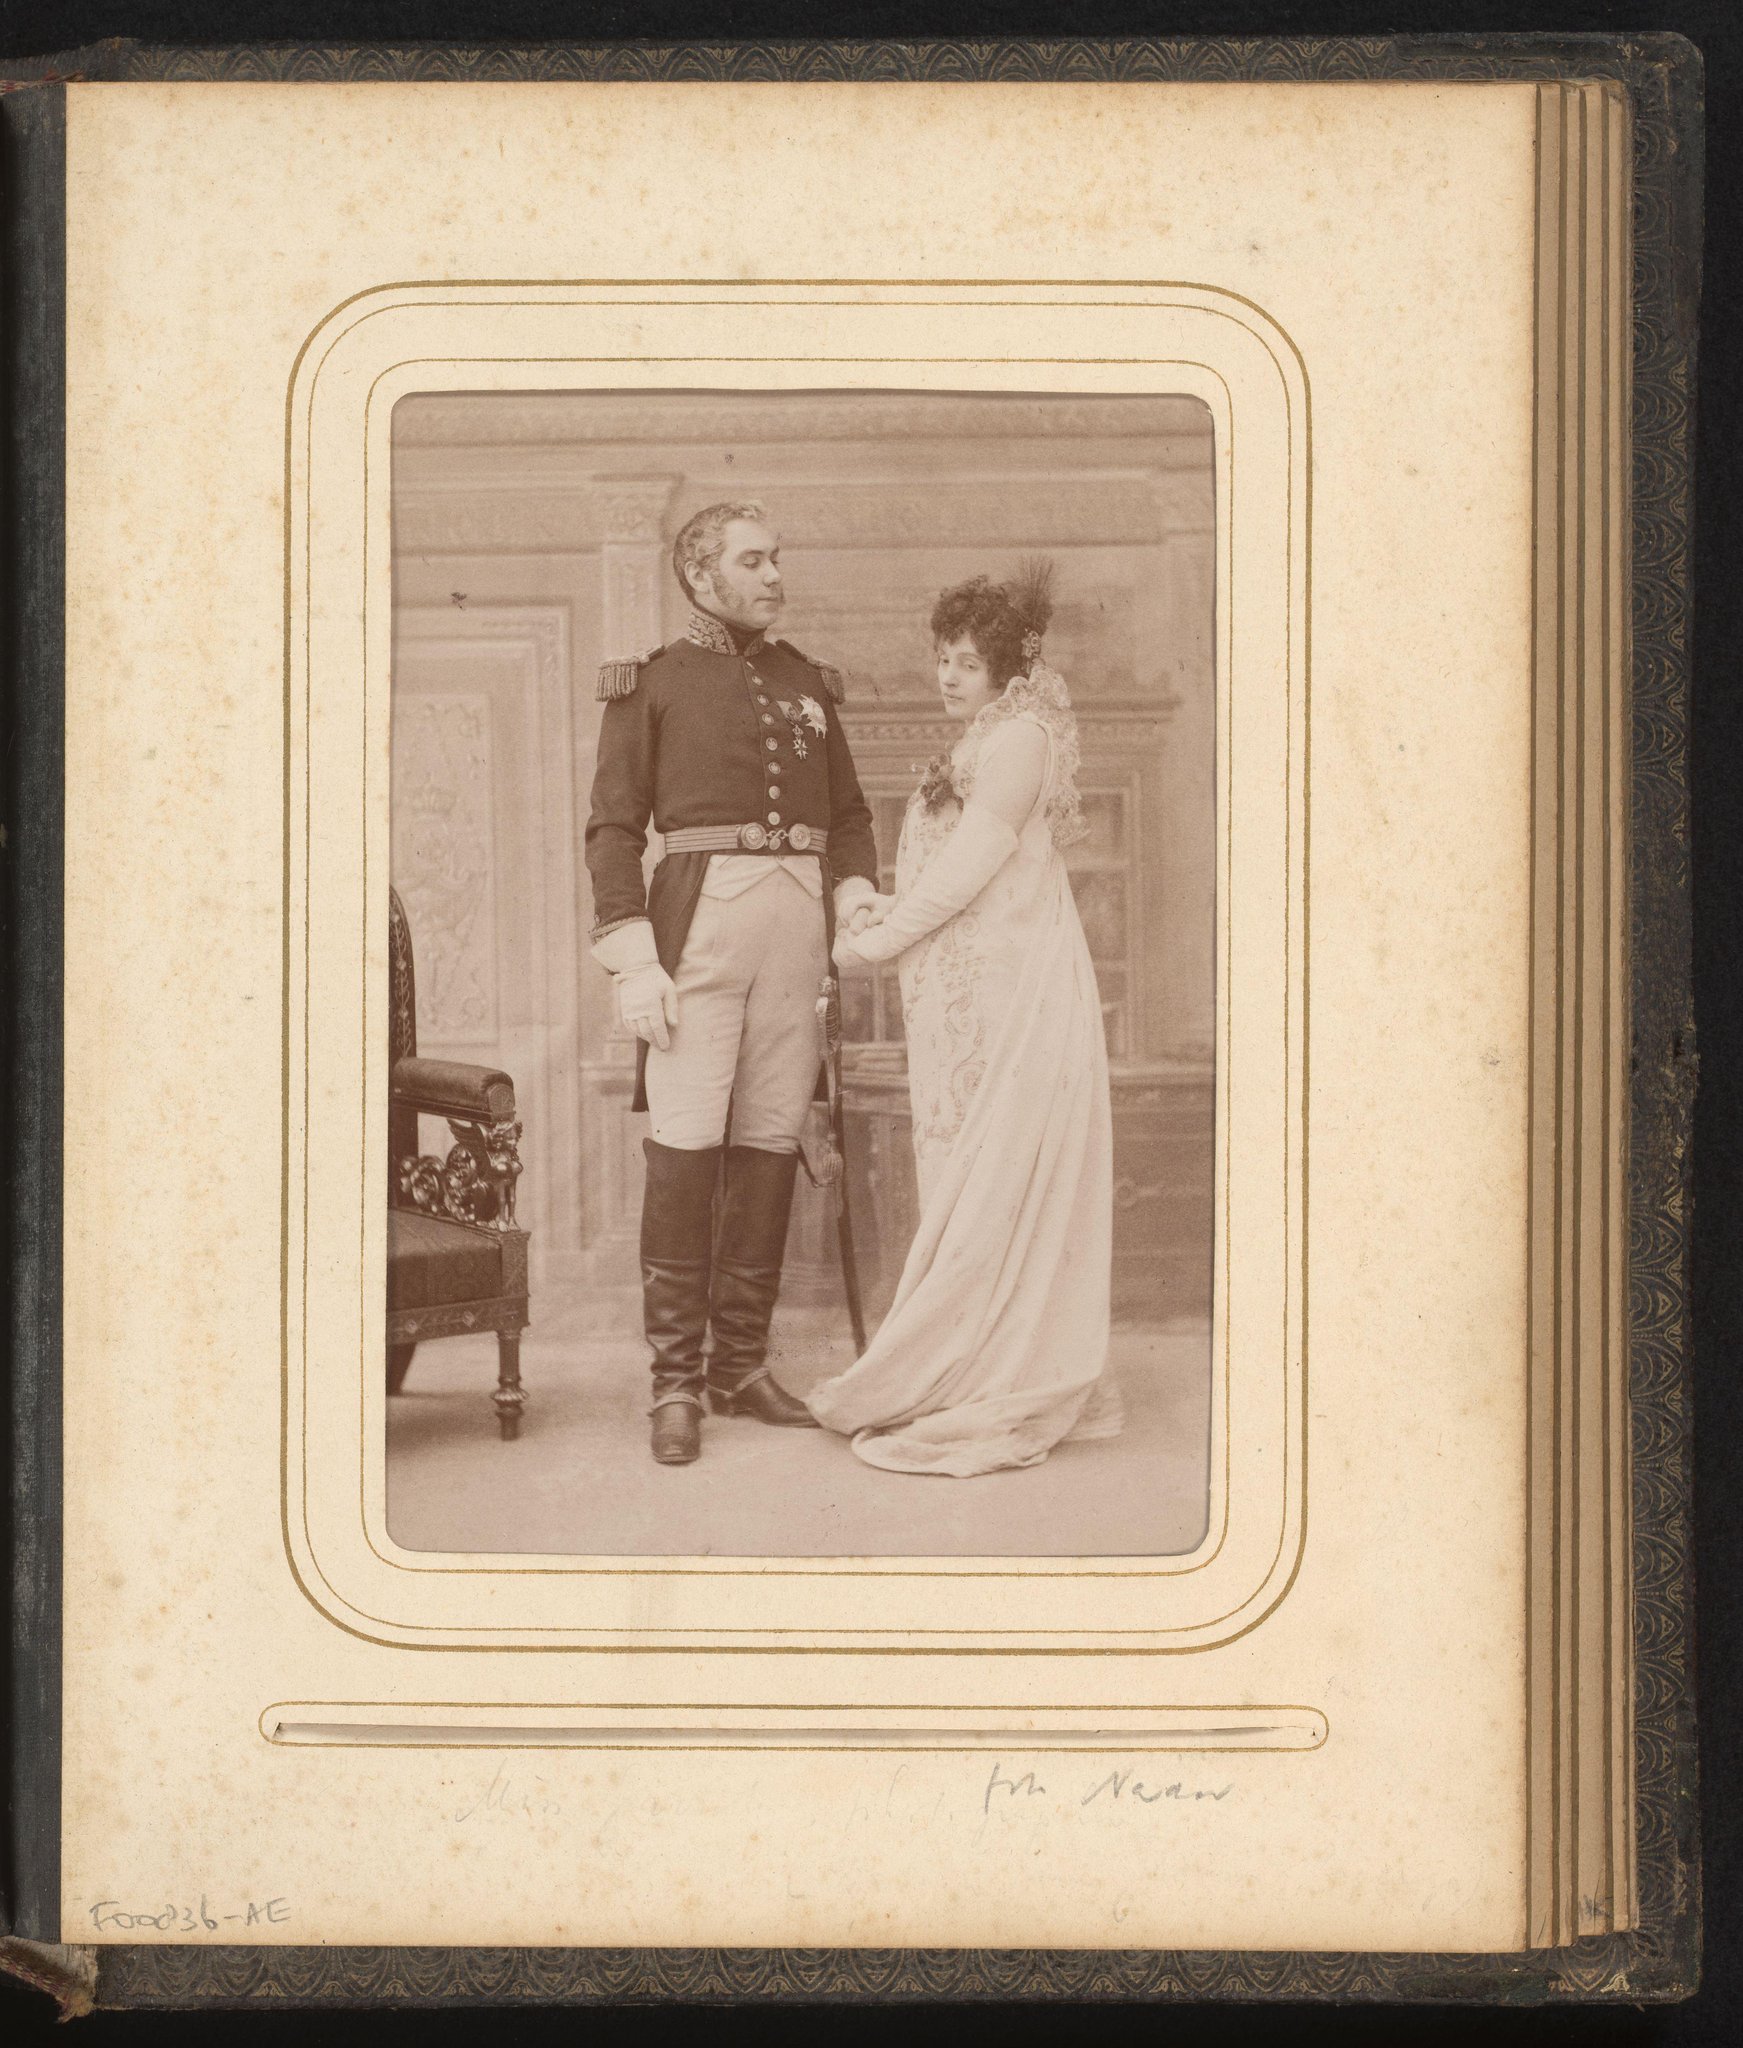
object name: cabinet photograph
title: Toneelscène met soldaat met dame in het wit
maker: félix nadar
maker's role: ballonvaarder, fotograaf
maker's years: 1820-1910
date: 1889-1900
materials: cardboard, photographic support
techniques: gelatin silver print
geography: paris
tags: group of actors, troupe; actors on the stage, portrait of actor, actress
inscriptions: inscription: ‘1889./ Nadar/ Paris 51, Rue d'Anjou/ 53, Rue des Mathurins’, annotation: ‘foto Nadar’